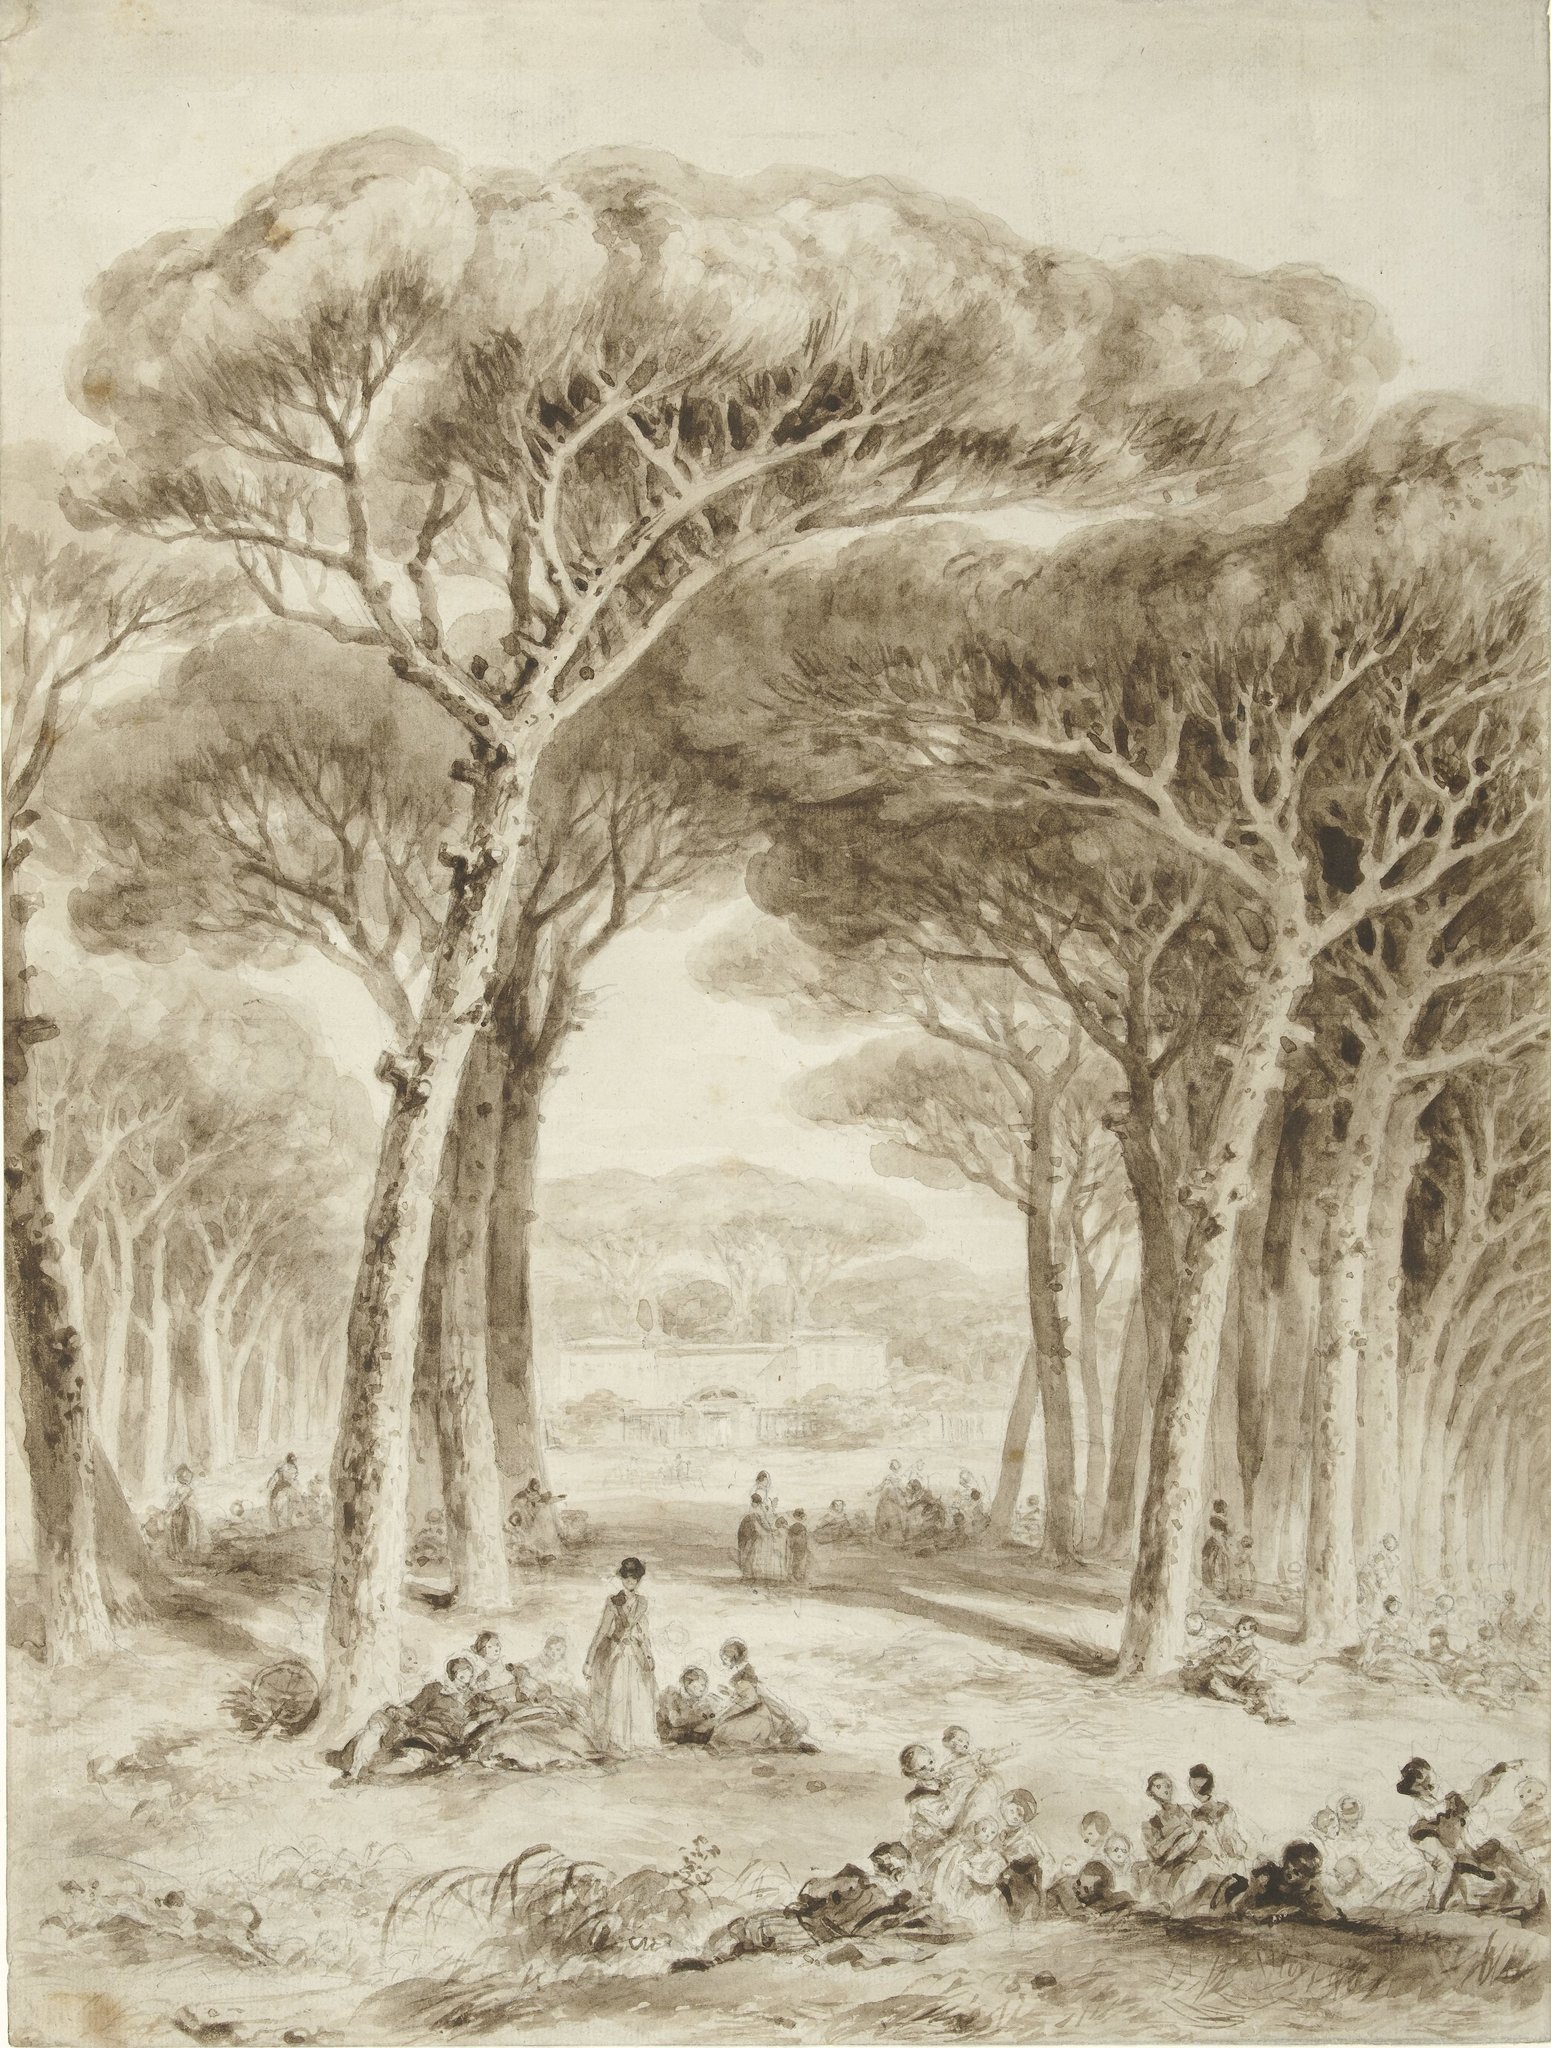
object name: drawing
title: Italian Landscape with Umbrella Pines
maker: jean honoré fragonard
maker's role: draughtsman, painter, print maker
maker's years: 1732-1806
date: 1773-1775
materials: chalk, paper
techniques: brush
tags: park, trees: pine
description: Born in southern France and trained in Italy, Fragonard was sensitive to a southern atmosphere. This is masterfully shown here, the golden light of Italy suggested by areas of untouched cream paper. Fragonard rendered the hazy distance of the background with shades of pale brown wash, while accentuating the foreground with undiluted brown ink.